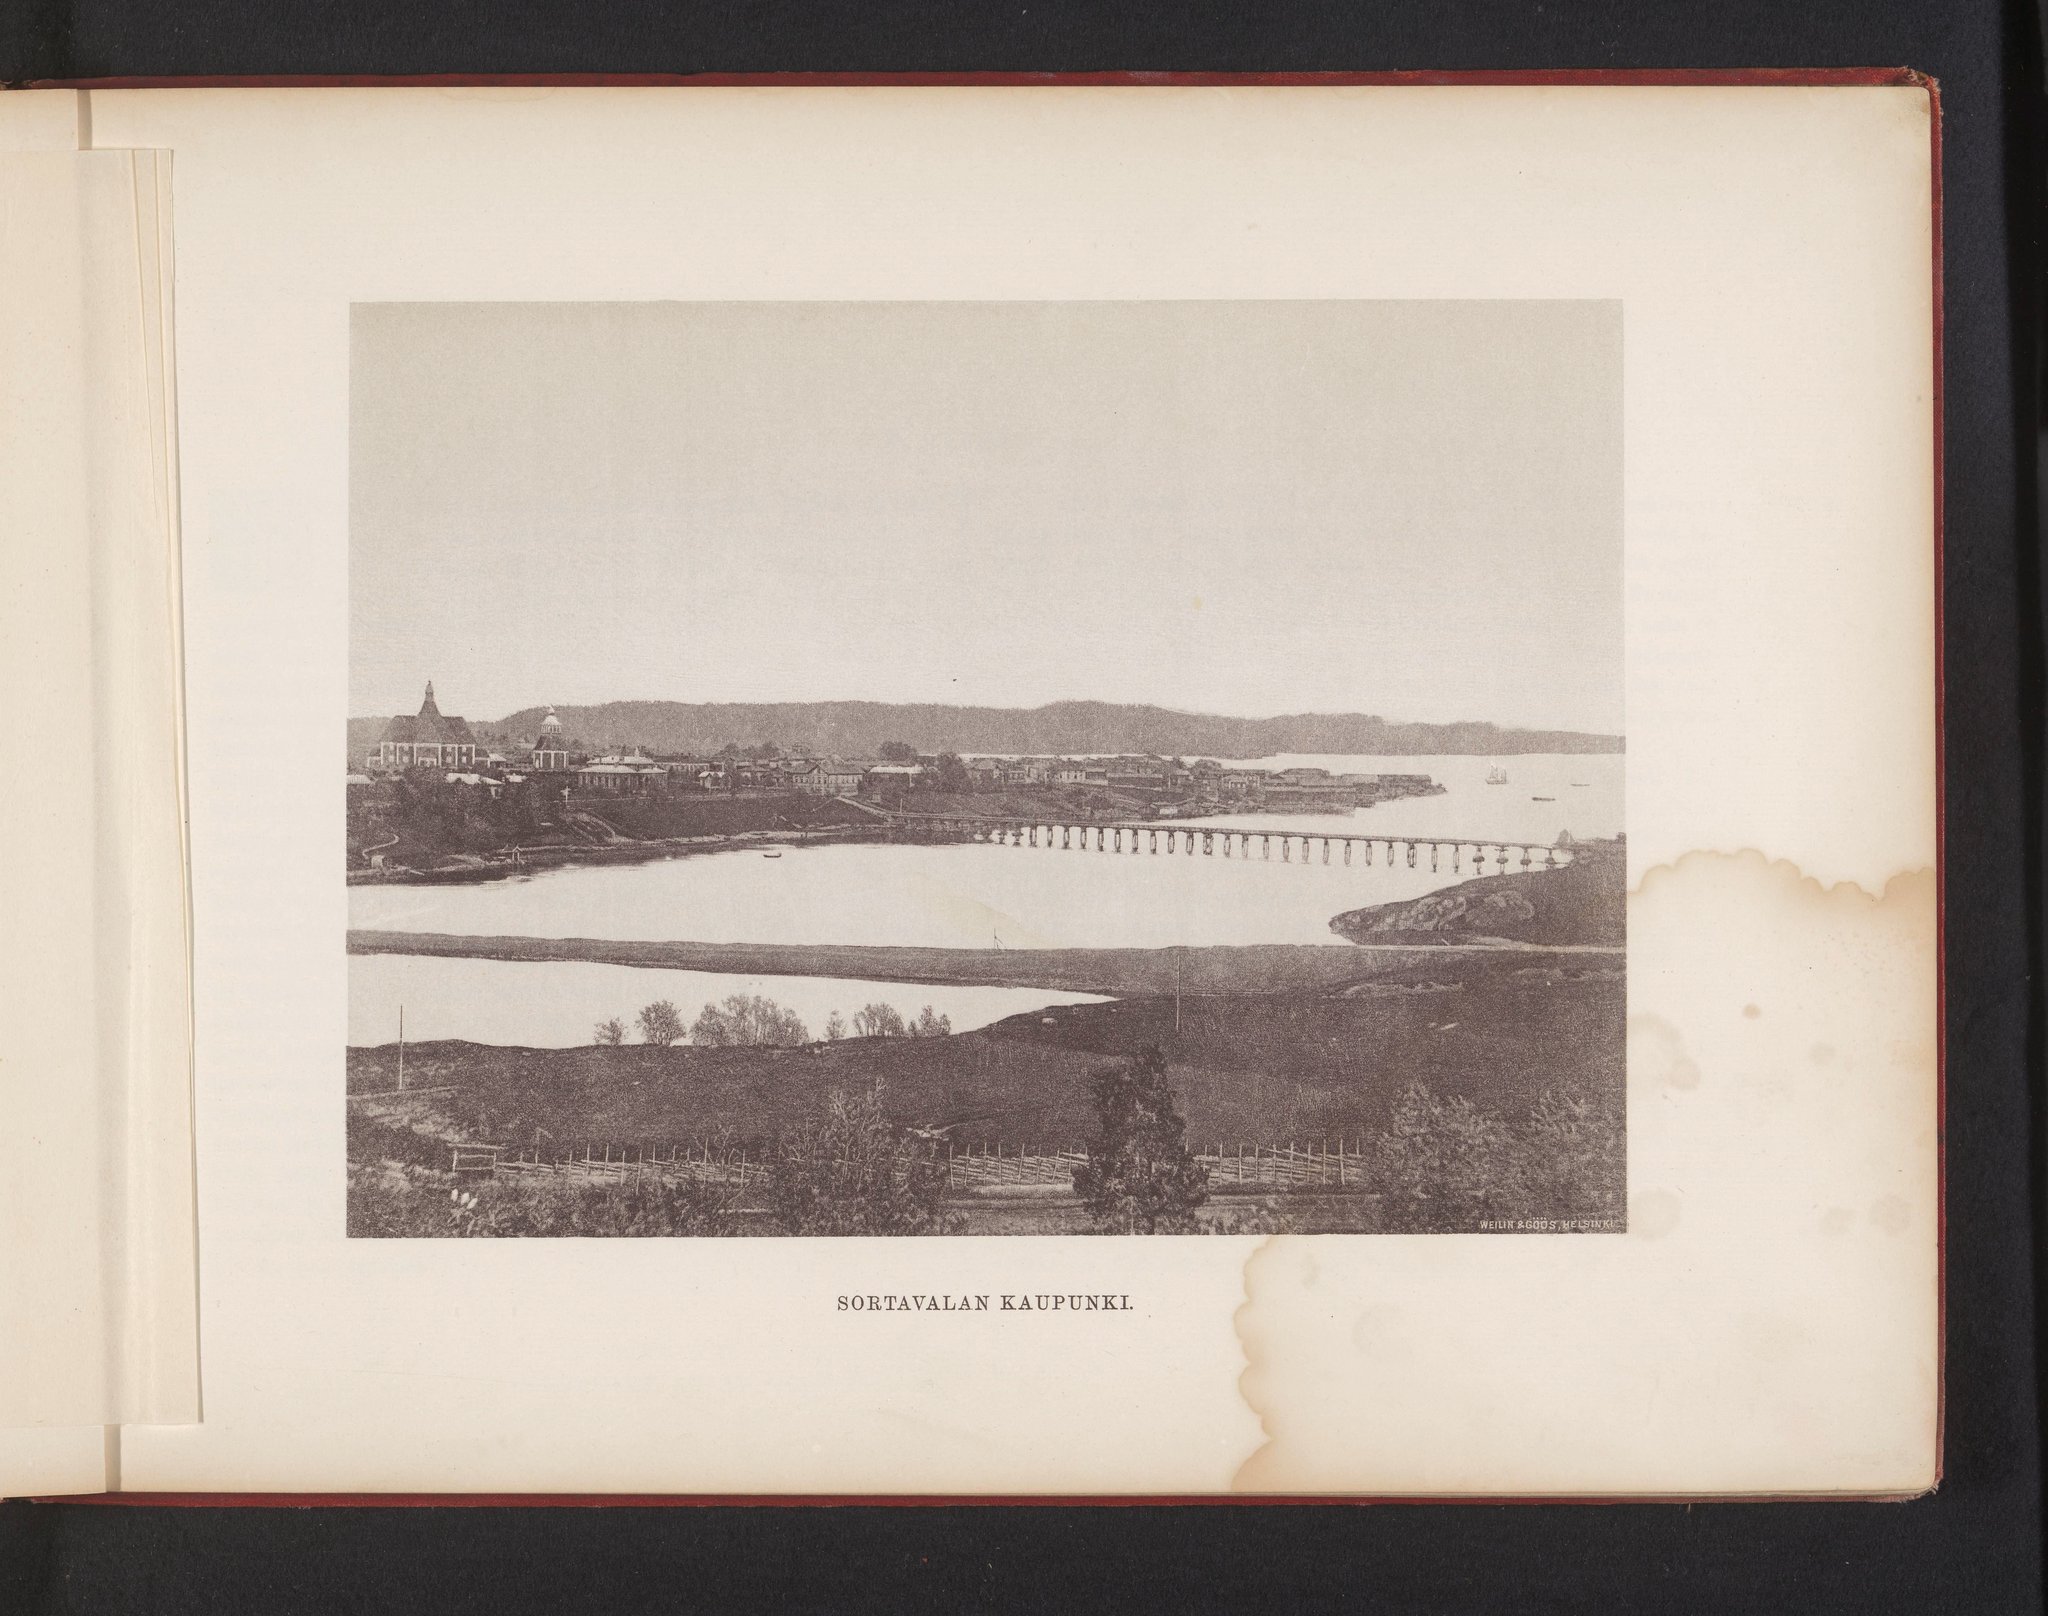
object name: page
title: Gezicht op Sortavala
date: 1888-1893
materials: paper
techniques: autotype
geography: sortavala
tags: city-view in general; 'veduta', landscapes with waters, waterscapes, seascapes (in the temperate zone), bridge